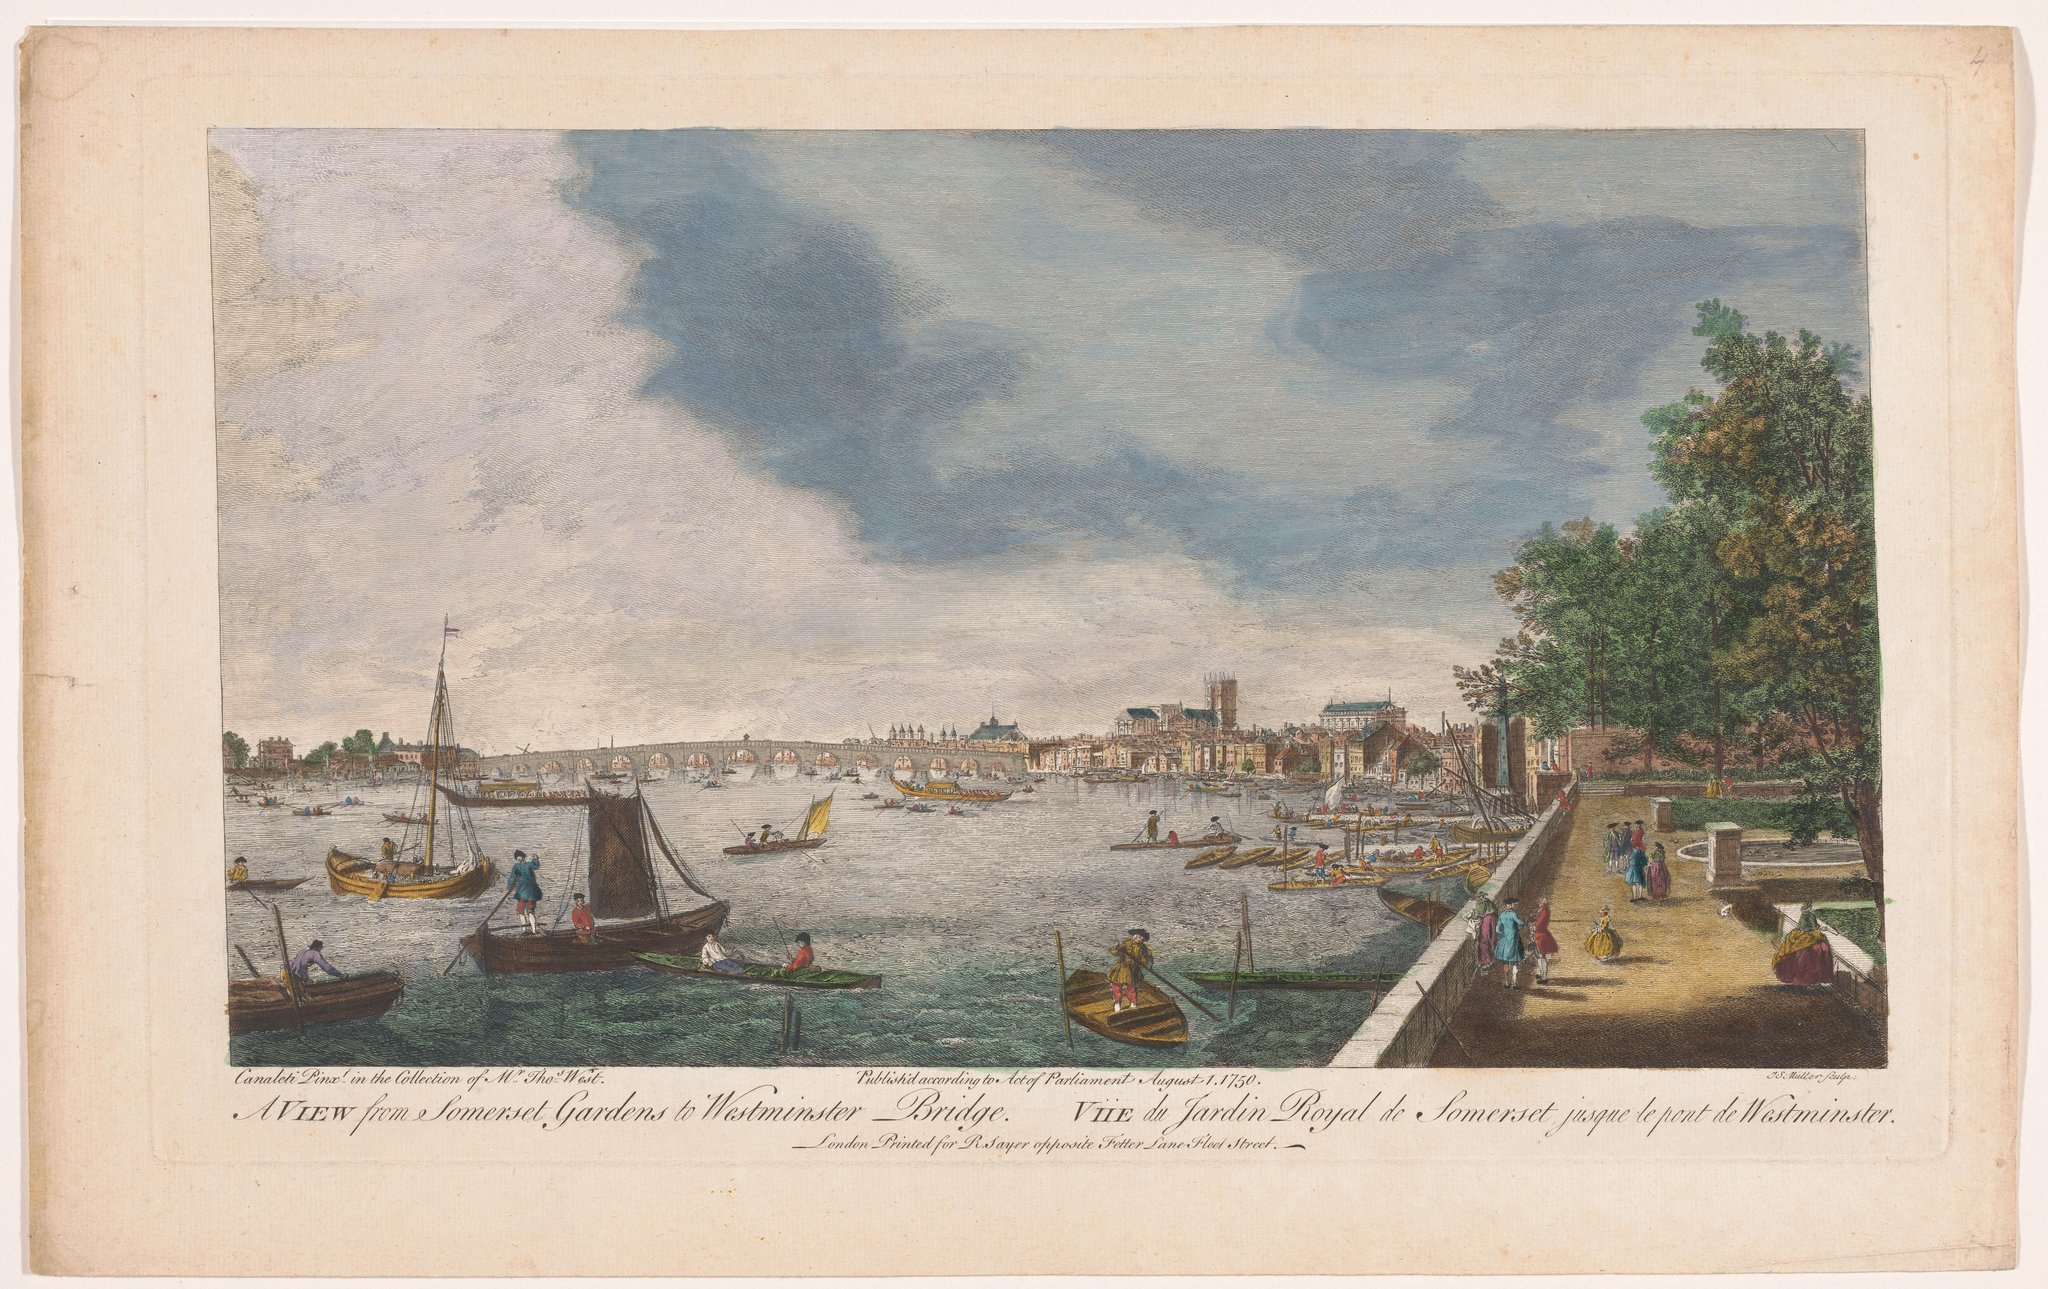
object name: print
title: Londen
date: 1750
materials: paper, watercolor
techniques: brush, etching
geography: london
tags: bridge in city across river, canal, etc. (+ city(-scape) with figures, staffage), sailing-ship, sailing-boat, garden, church (exterior), rowing-boat, canoe, etc., westminster abbey, thames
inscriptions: watermark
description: De serie “Londen” bevat 52 prenten met de nummers 1-52, waarvan dit nummer 4 is.